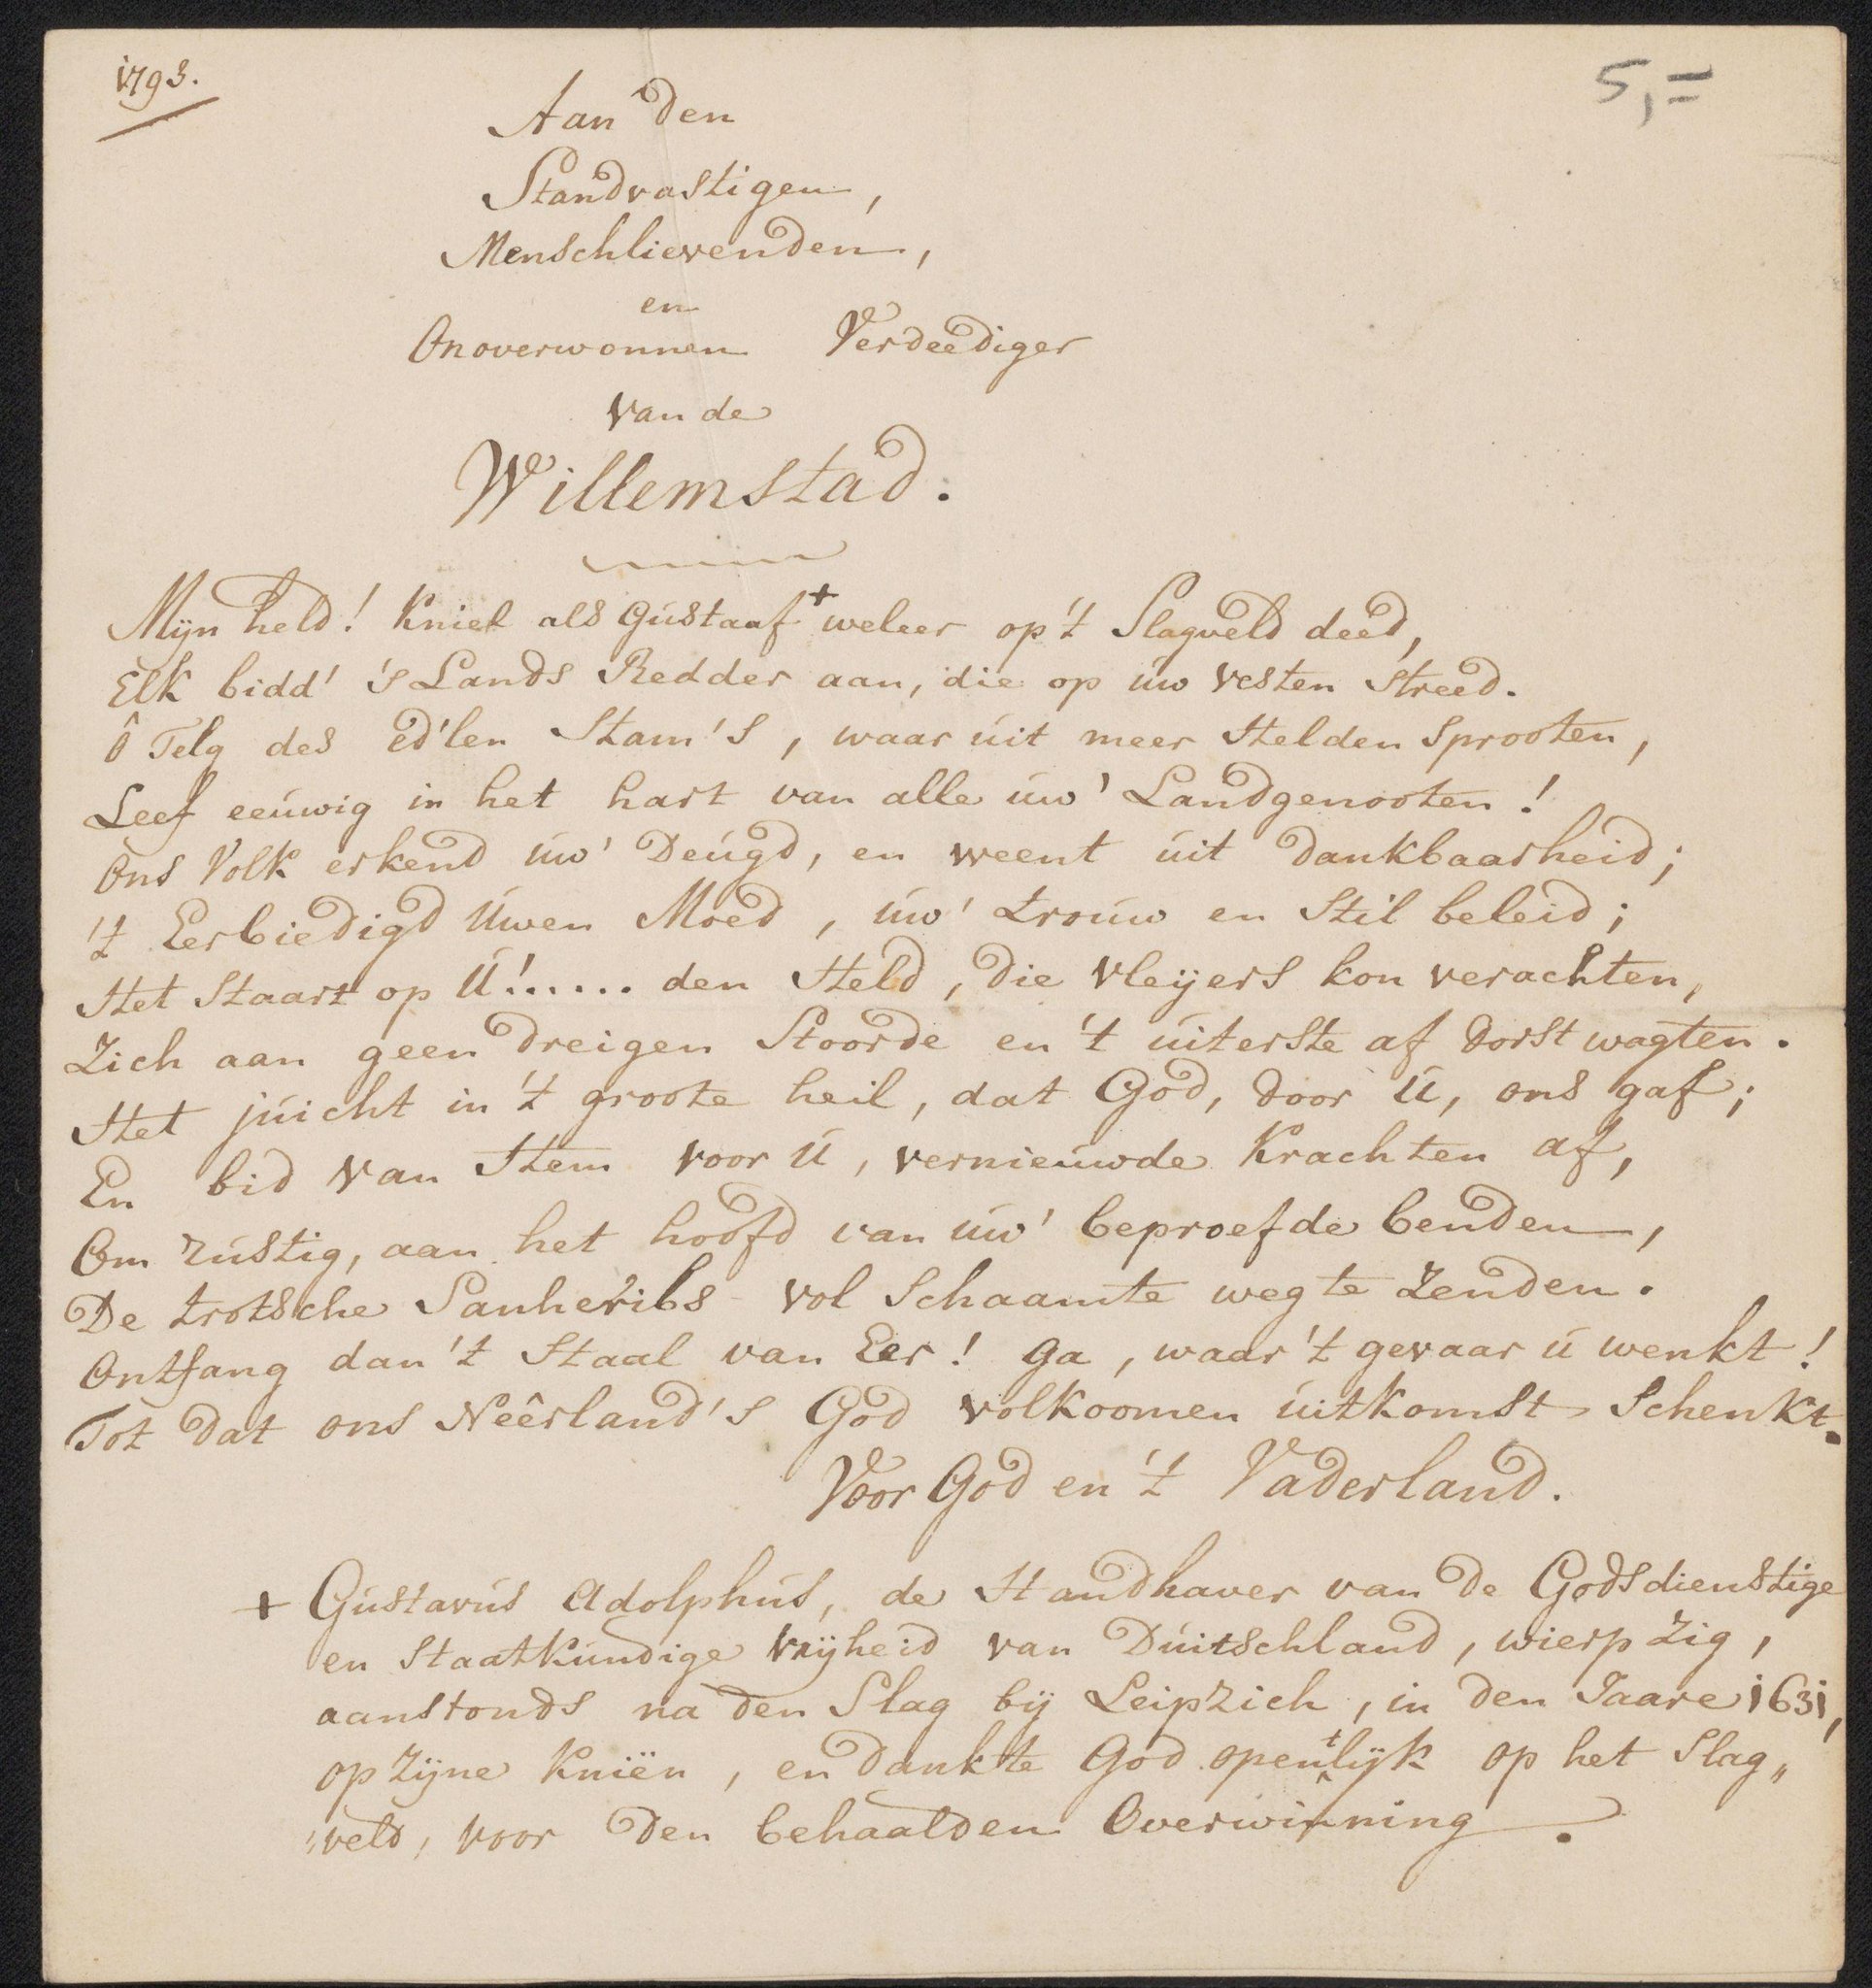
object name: poem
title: Gedicht aan Carel baron van Boetzelaer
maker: didericus rooleeuw lepie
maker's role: schrijver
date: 1793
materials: ink, paper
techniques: pen, writing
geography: the hague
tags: the hague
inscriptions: watermark